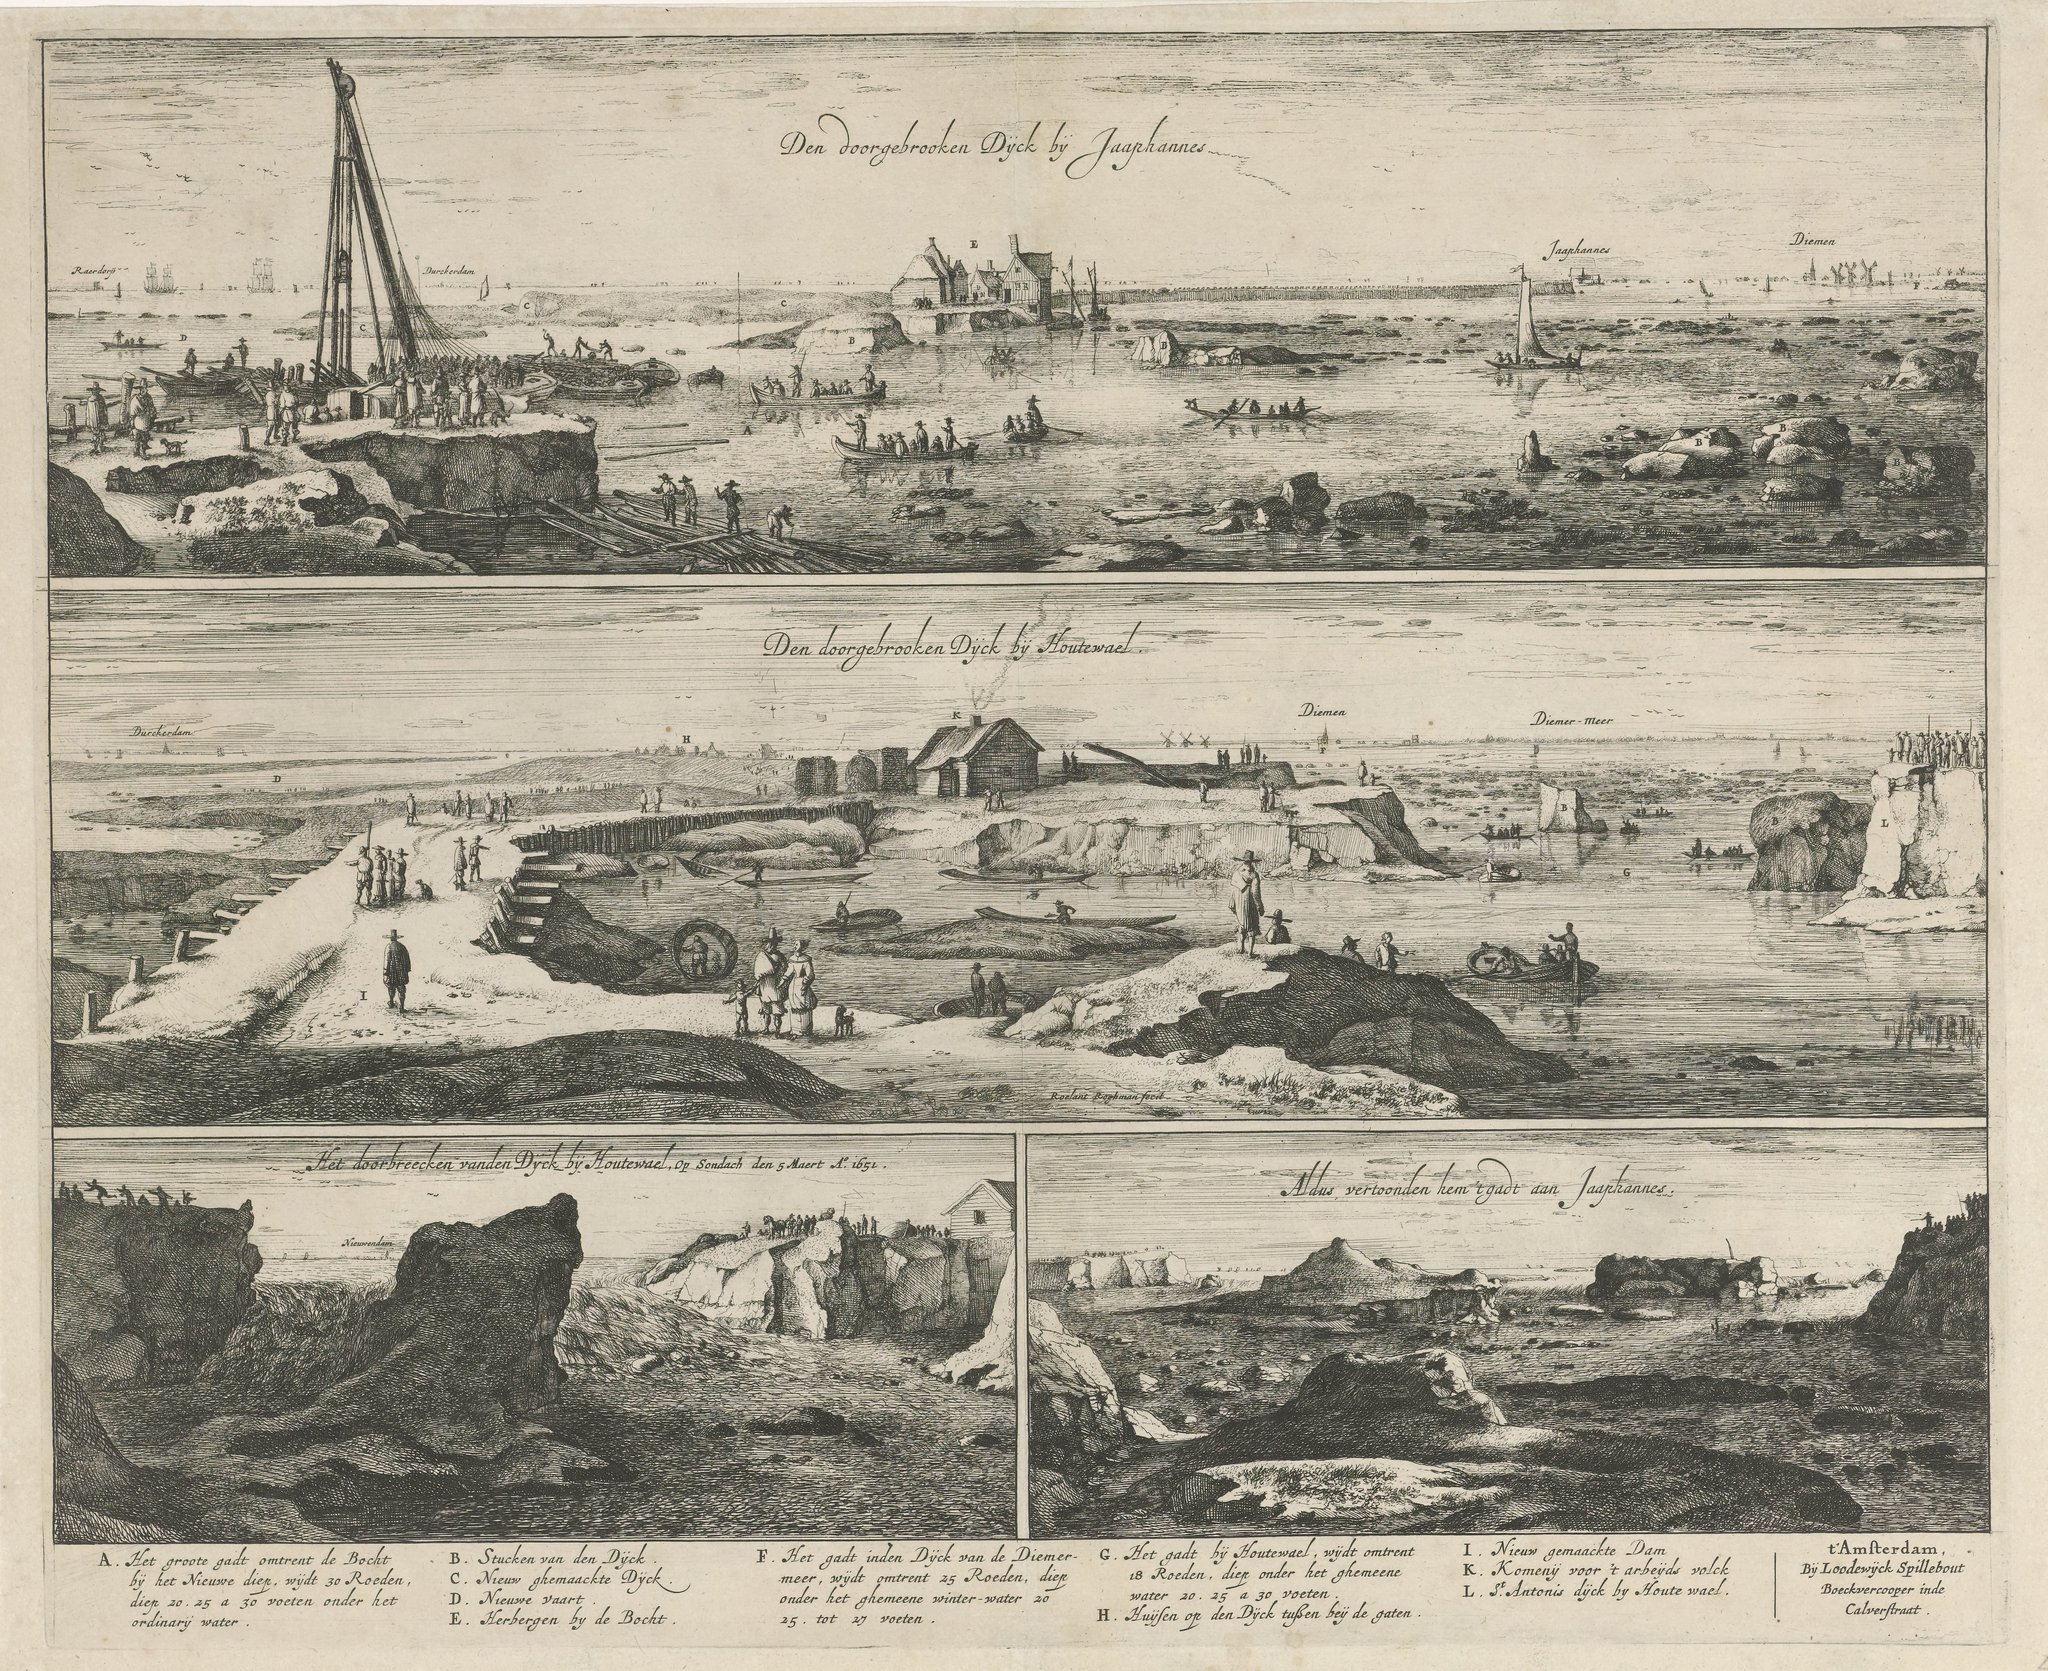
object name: print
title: Doorgebroken Sint-Antoniesdijk bij Jaap Hannes, 1651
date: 1651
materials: paper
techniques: etching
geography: amsterdam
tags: dike-break, building activities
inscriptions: collector's mark: Lugt 2228a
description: Blad met twee voorstellingen. Boven heiwerkzaamheden tijdens het herstel van de op 5 maart 1651 doorgebroken Sint-Antoniesdijk of Diemerzeedijk bij de herberg Jaap Hannes. In het midden de herbergen bij de Bocht, in de verte Durgerdam en Diemen. Onder de doorgebroken dijk bij Houtewael. Twee onderdelen van een grote plaat bestaande uit vier afbeeldingen en een tekstblad met een vers.